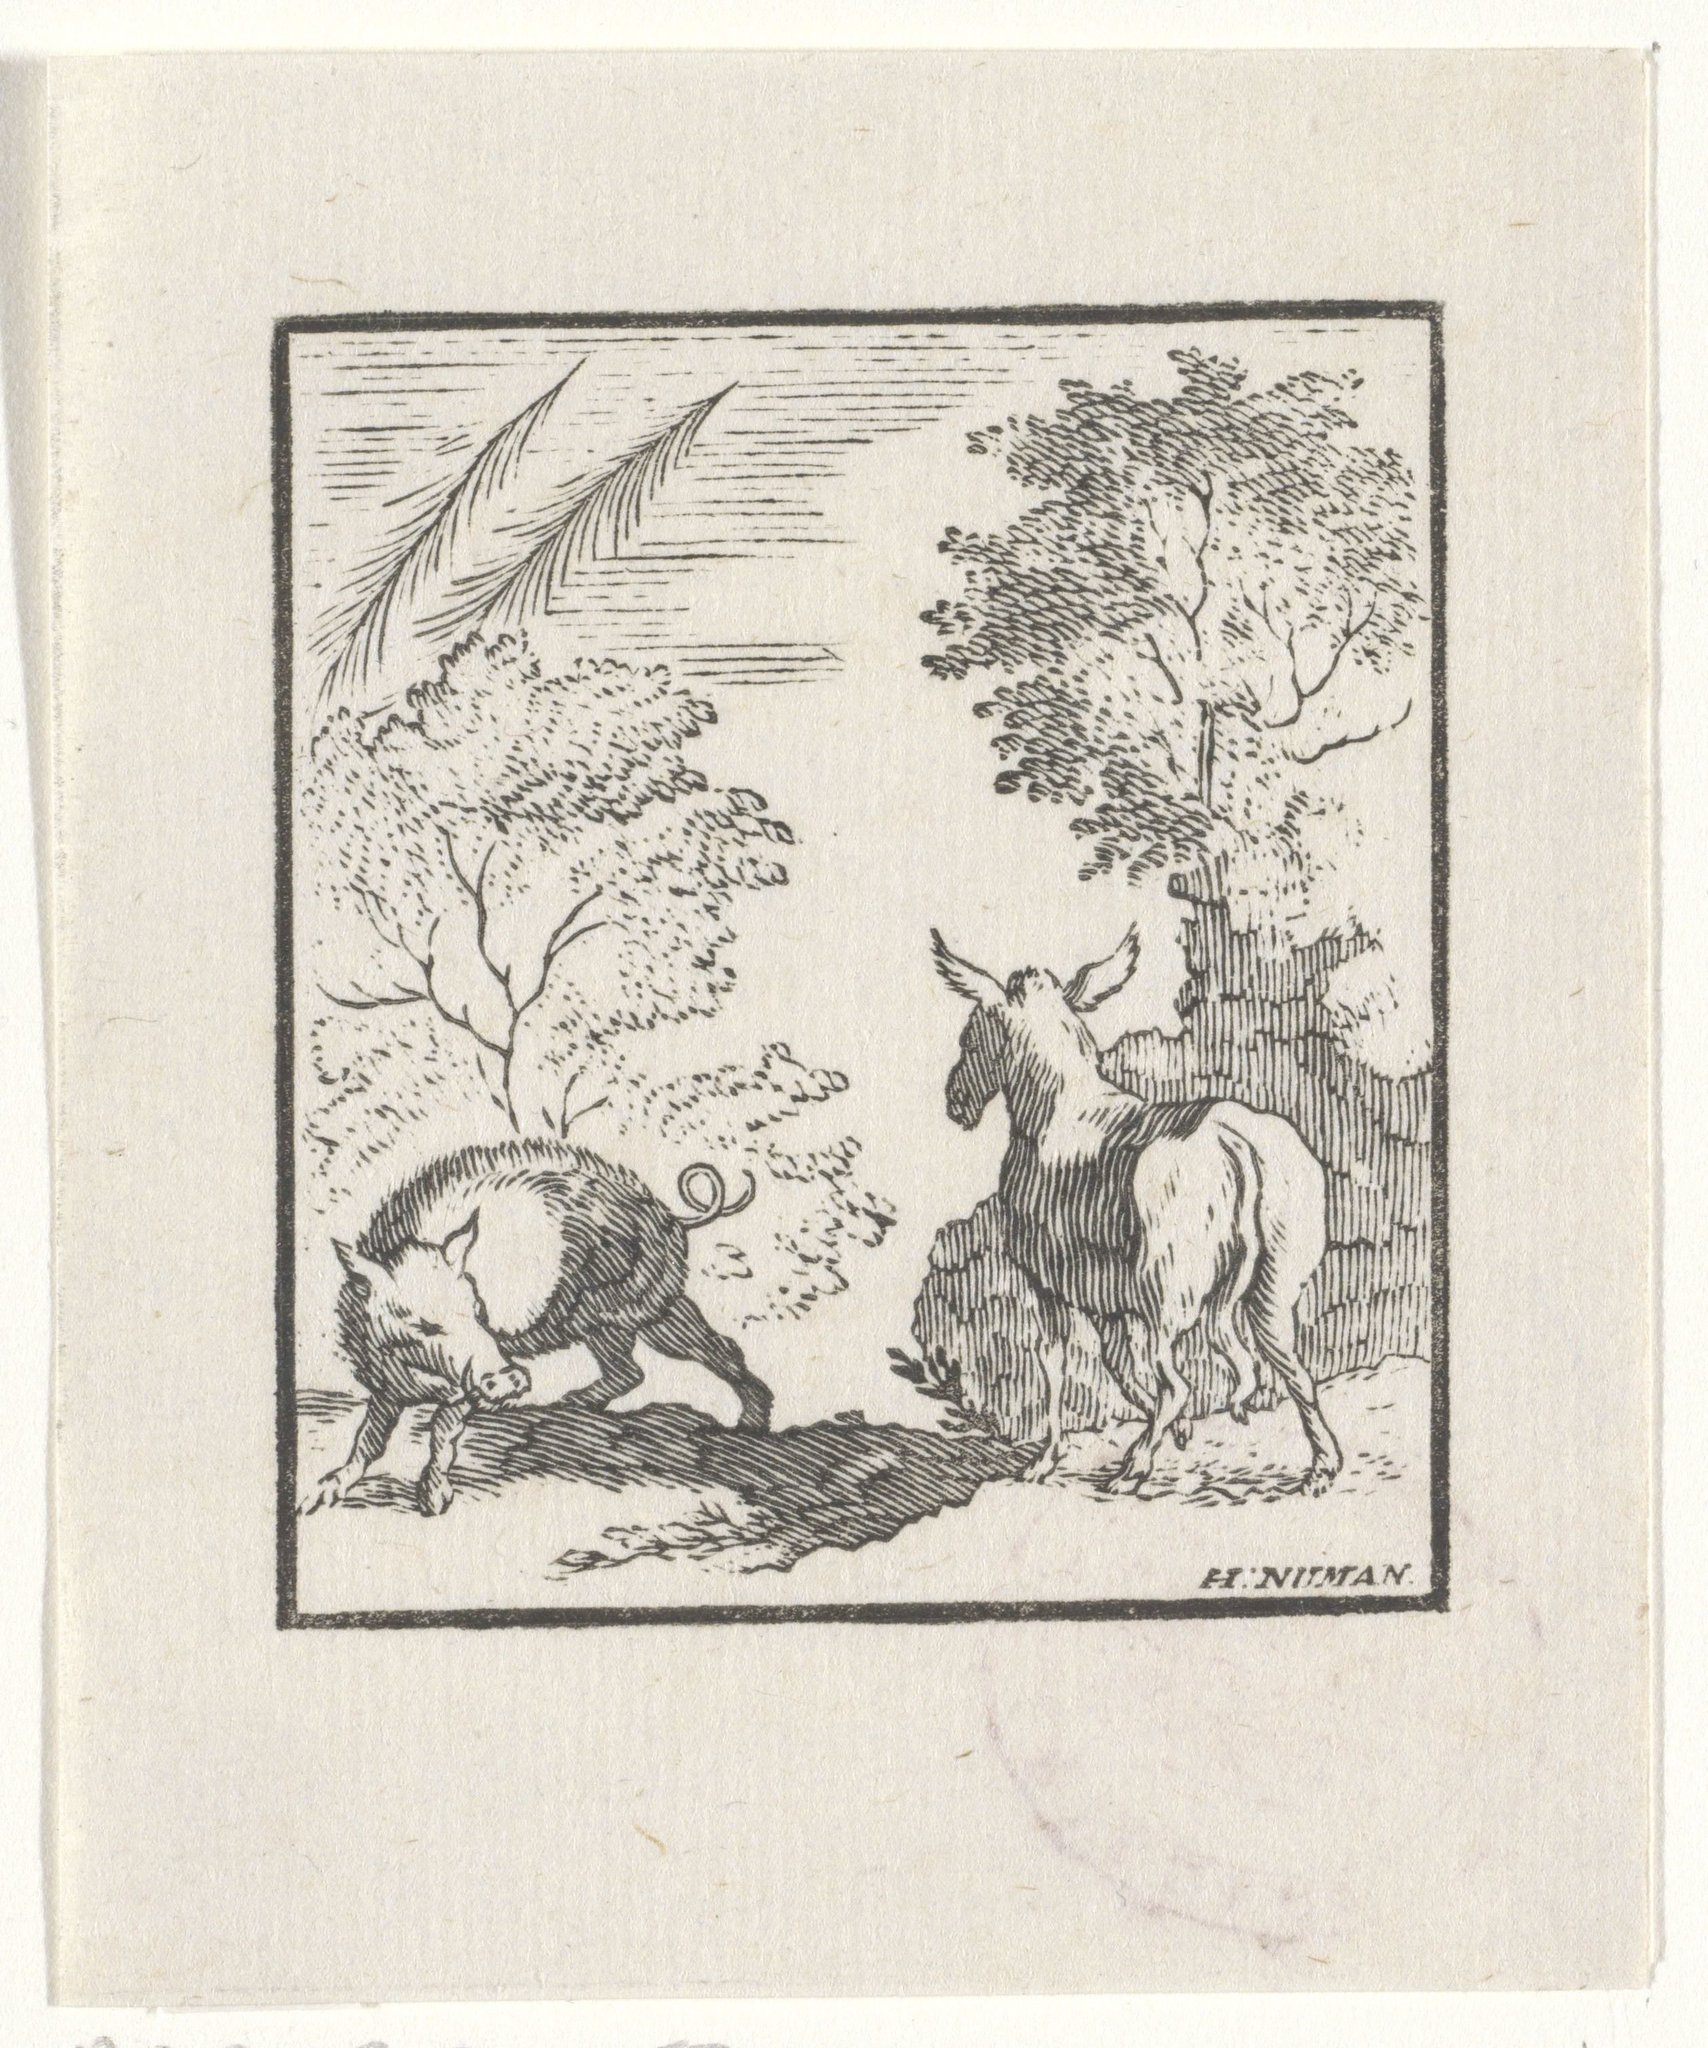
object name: print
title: Voorstelling van een verhaal uit de Aesopus fabelen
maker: hendrik numan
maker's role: draughtsman, print maker, publisher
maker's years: 1736-1788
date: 1746-1788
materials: paper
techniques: woodcut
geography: haarlem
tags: fables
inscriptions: collector's mark: Lugt 240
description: Een zwijn en een geit staan tegenover elkaar.